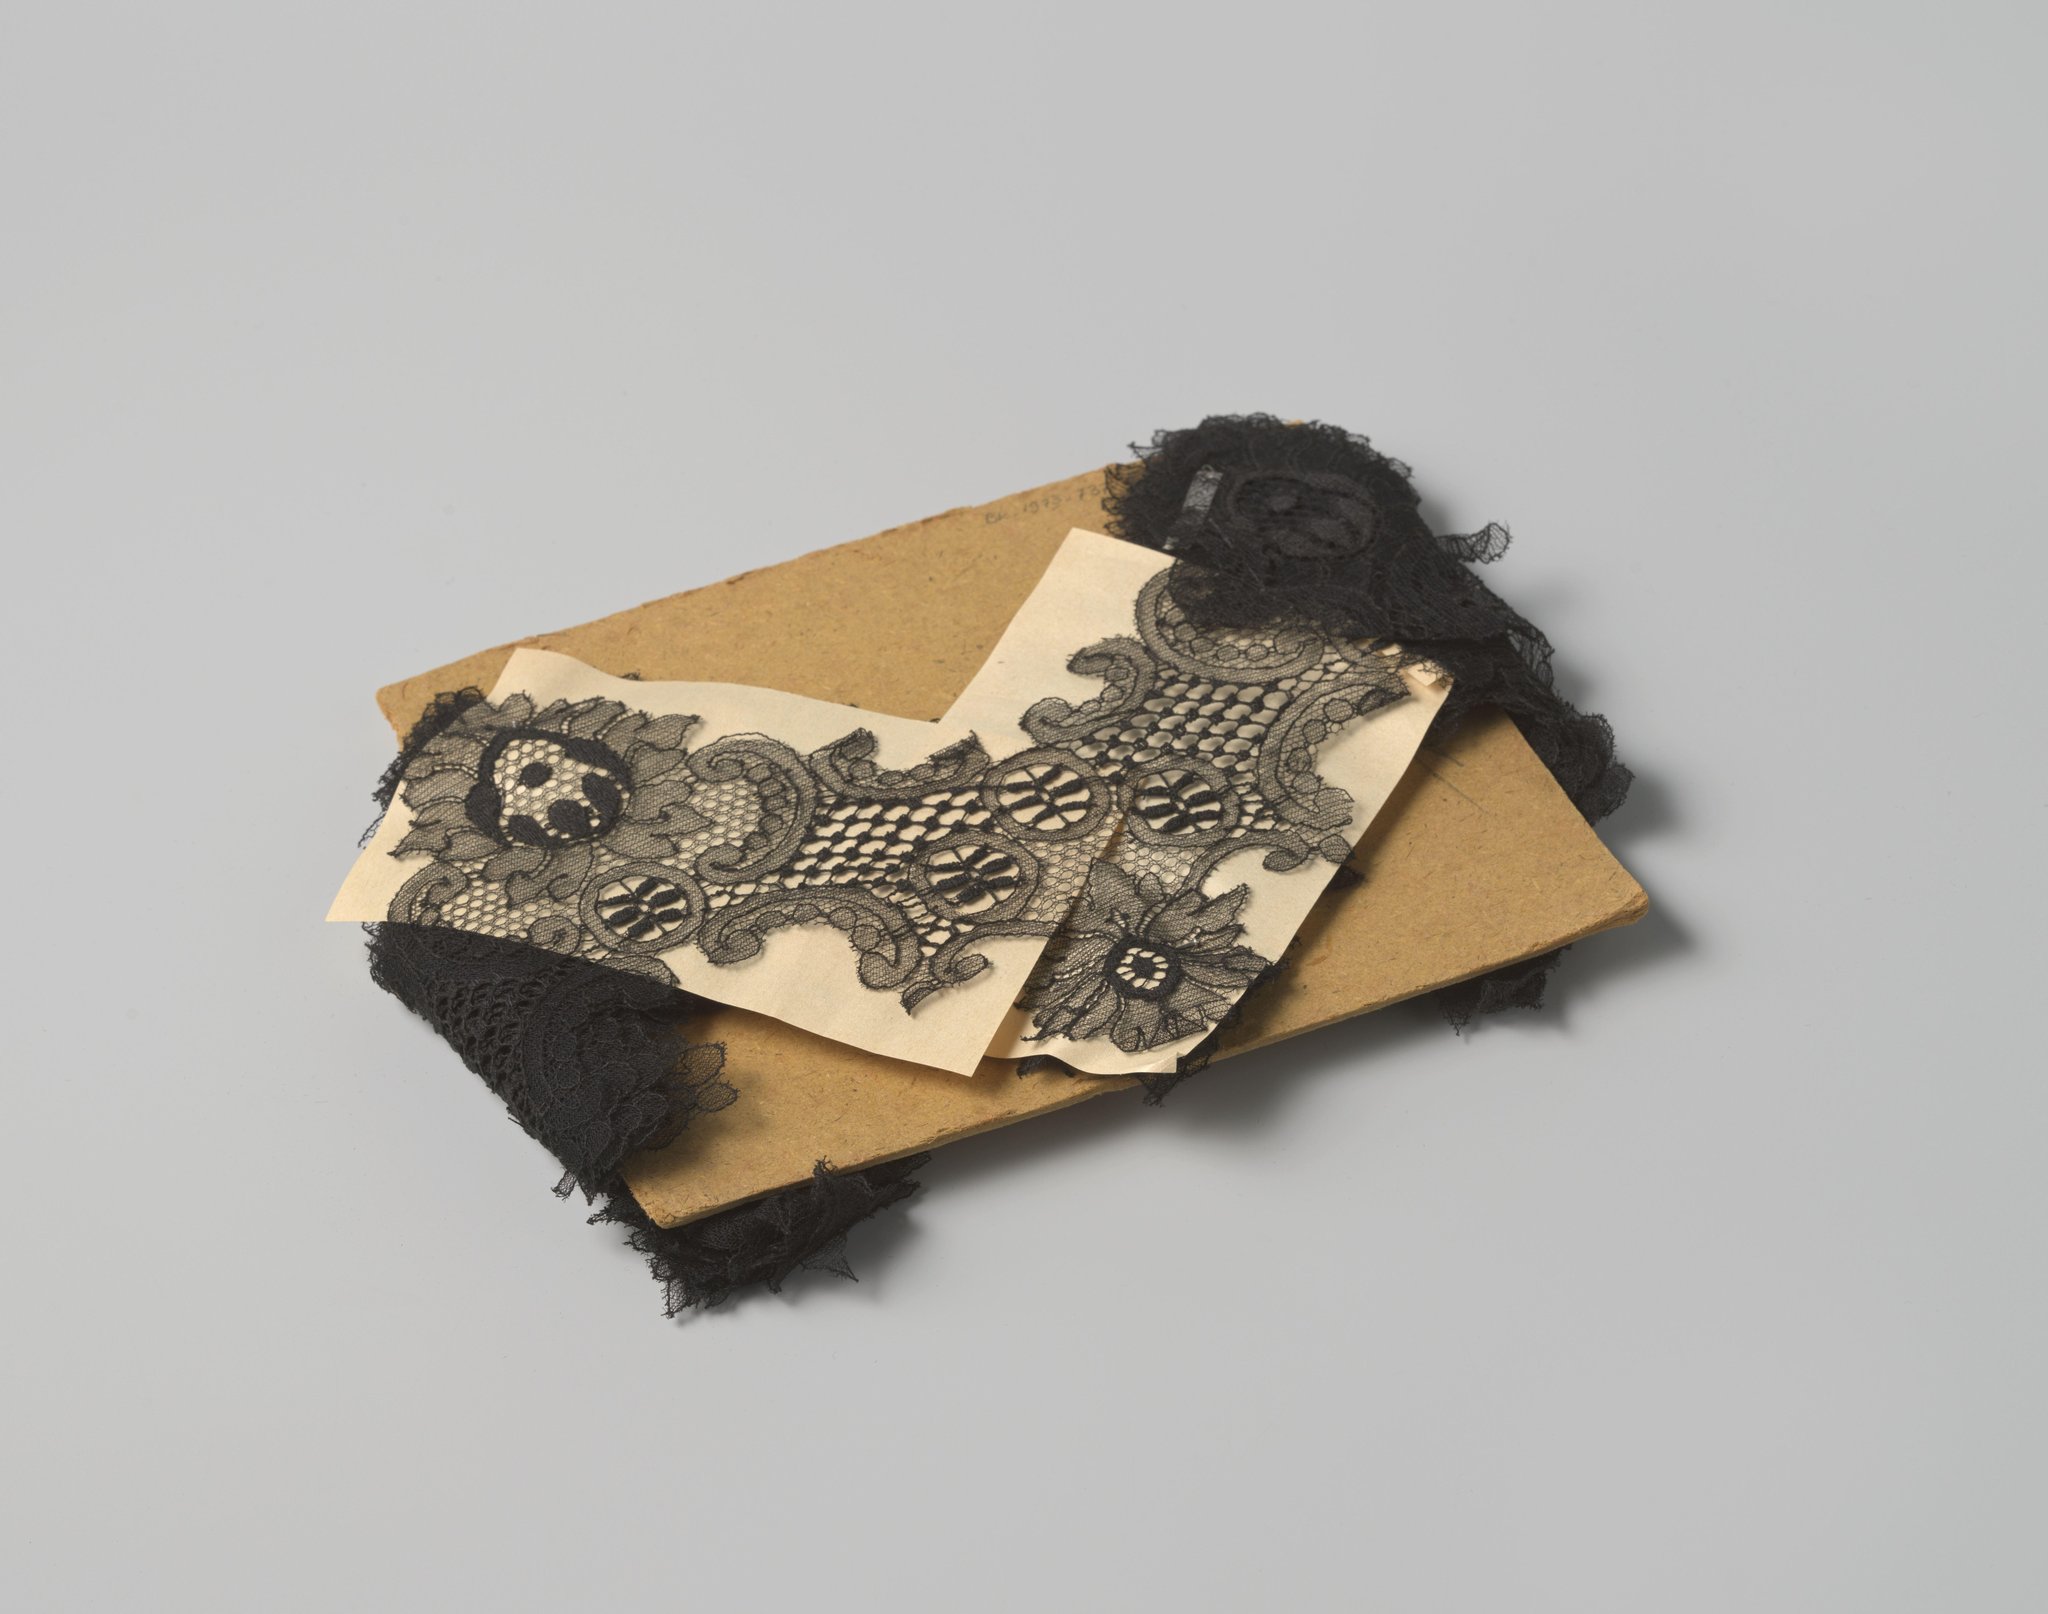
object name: strip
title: Strook tweezijdig geschulpte zwarte kant met motief van bladeren, c-vormige voluten en wielen, op zachtboard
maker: gustav schnitzler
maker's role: paraplufabrikant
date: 1925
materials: lace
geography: nijmegen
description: Strook tweezijdig geschulpte zwarte kant met motief van bladeren, c-vormige voluten en wielen, op zachtboard.